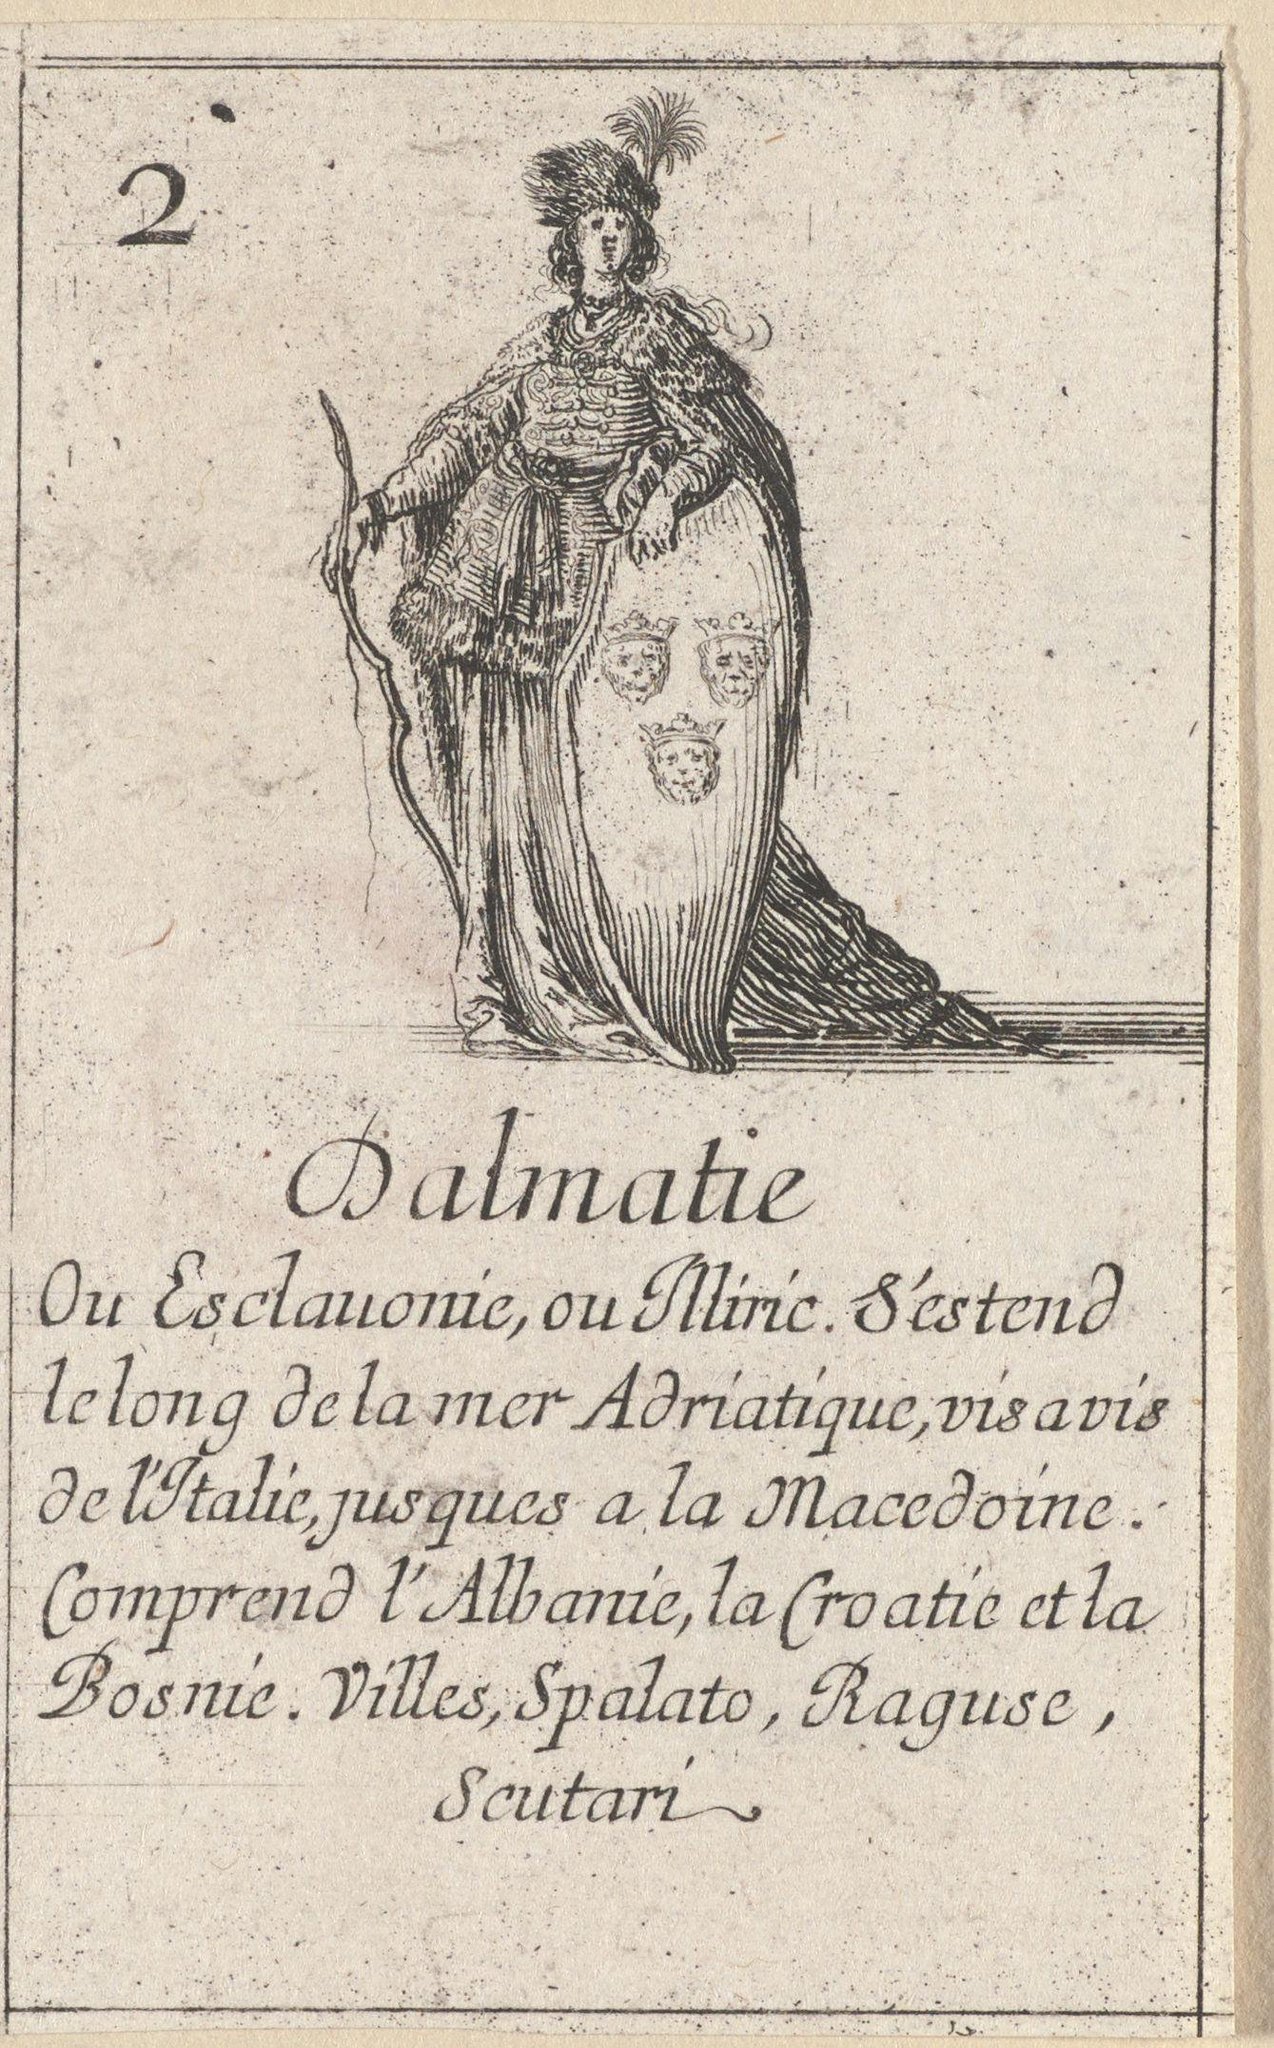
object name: playing card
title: Kaartspel geografie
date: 1620-1664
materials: paper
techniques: etching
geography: paris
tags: europeans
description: Deze prent maakt deel uit van een kaartspel met 52 kaarten met voorstellingen van vrouwen uit landen over de hele wereld. De serie is uitgedacht door Jean Desmarests de Saint-Sorlin in opdracht van Kardinaal Mazarin. Het kaartspel werd gemaakt voor de jonge Lodewijk XIV, samen met het Jeu des Fables, Jeu des Reynes Renommées en Jeu des Rois de France.